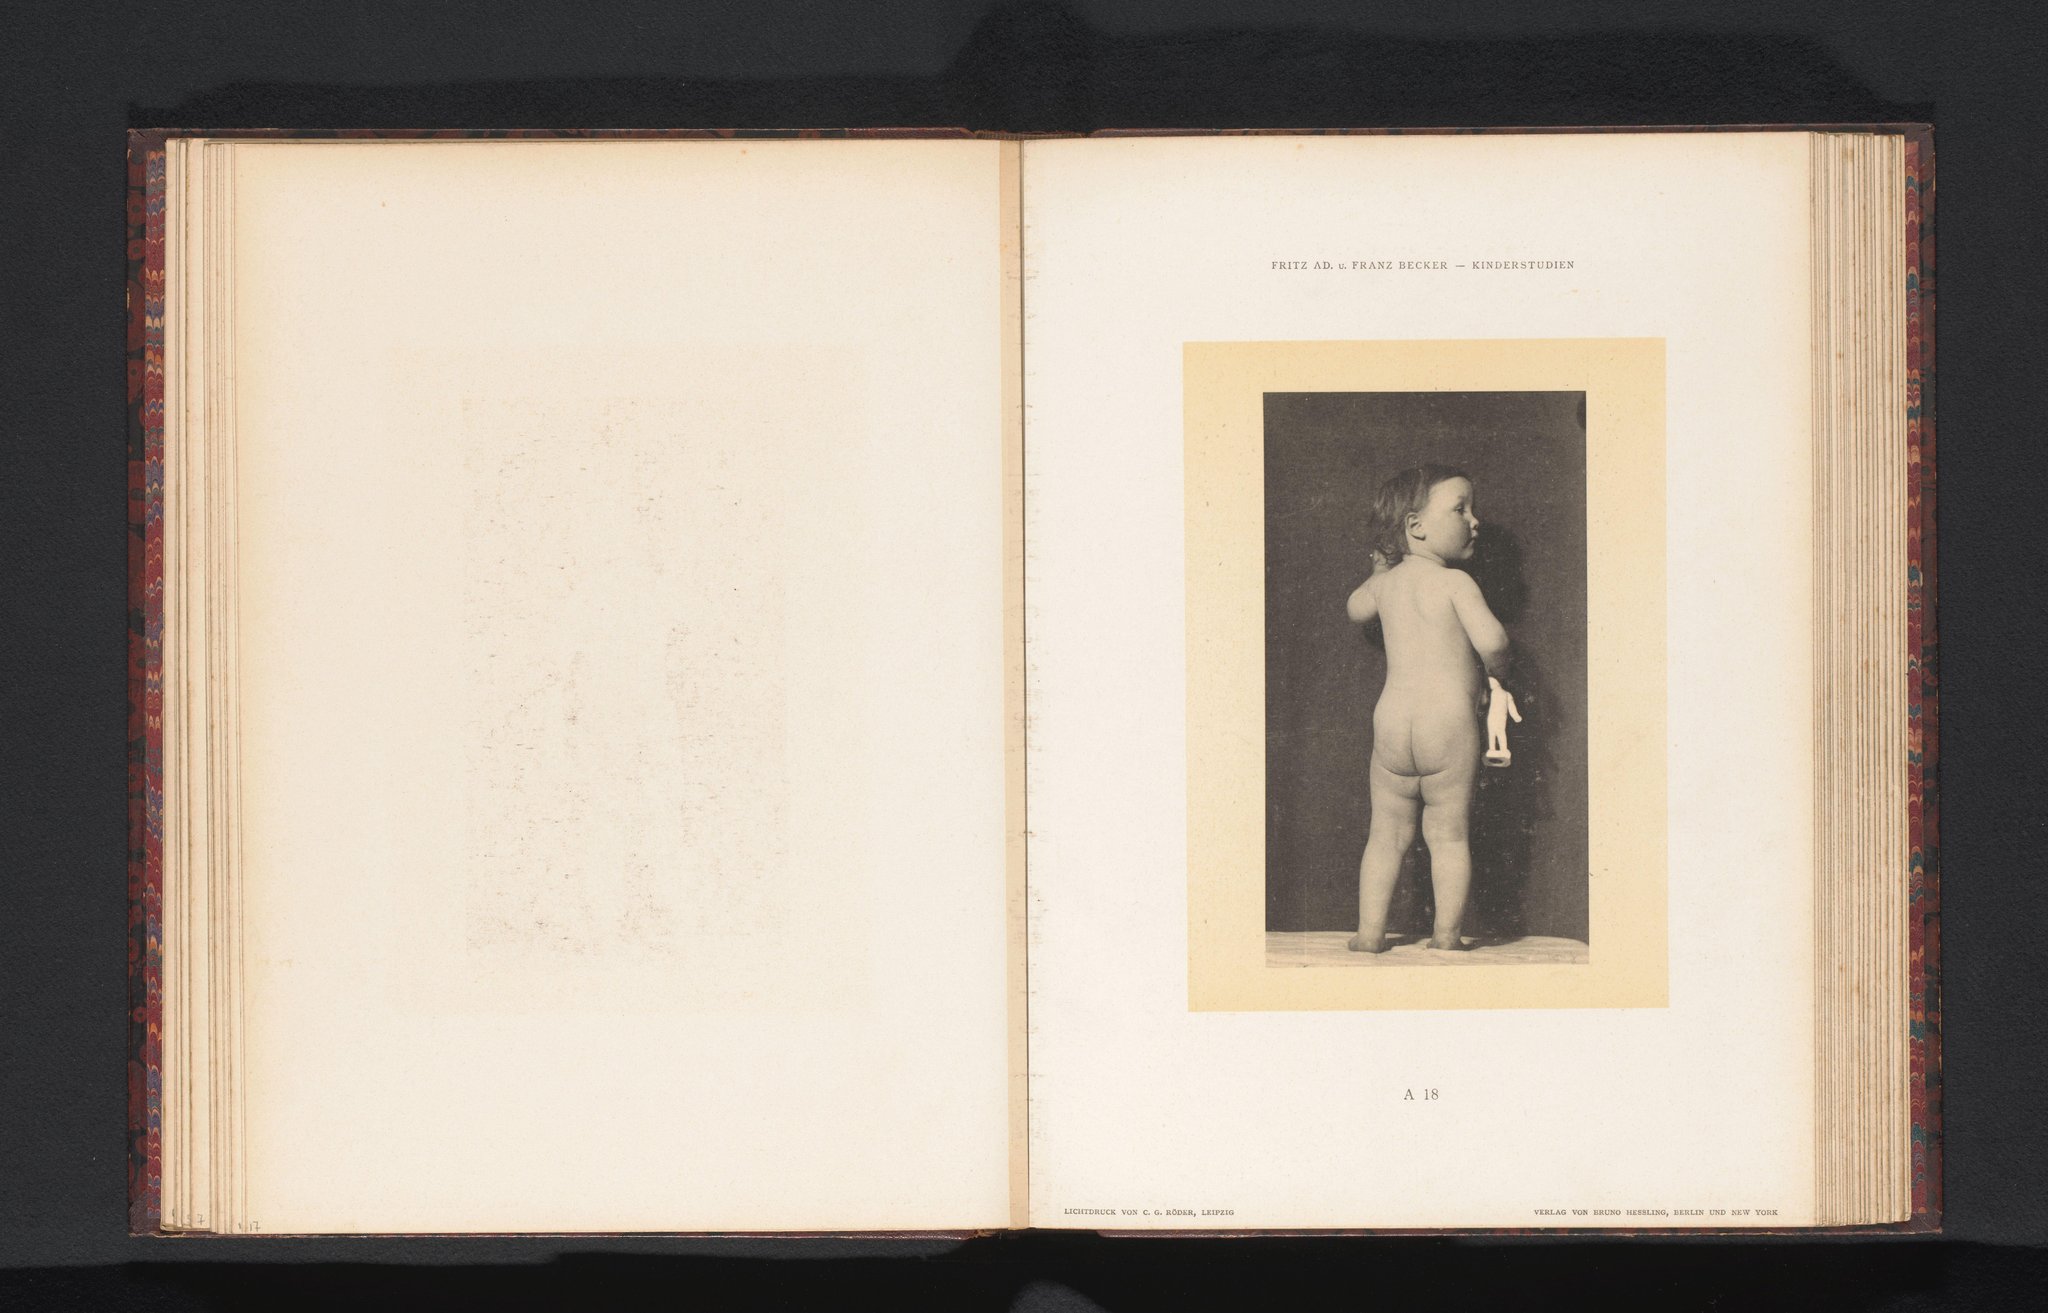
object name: photomechanical print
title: Staand naakt kind, op de rug gezien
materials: paper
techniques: photograph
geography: leipzig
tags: tot, toddler ~ the ages of man, standing figure (+ back view)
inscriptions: number: ‘A 18’